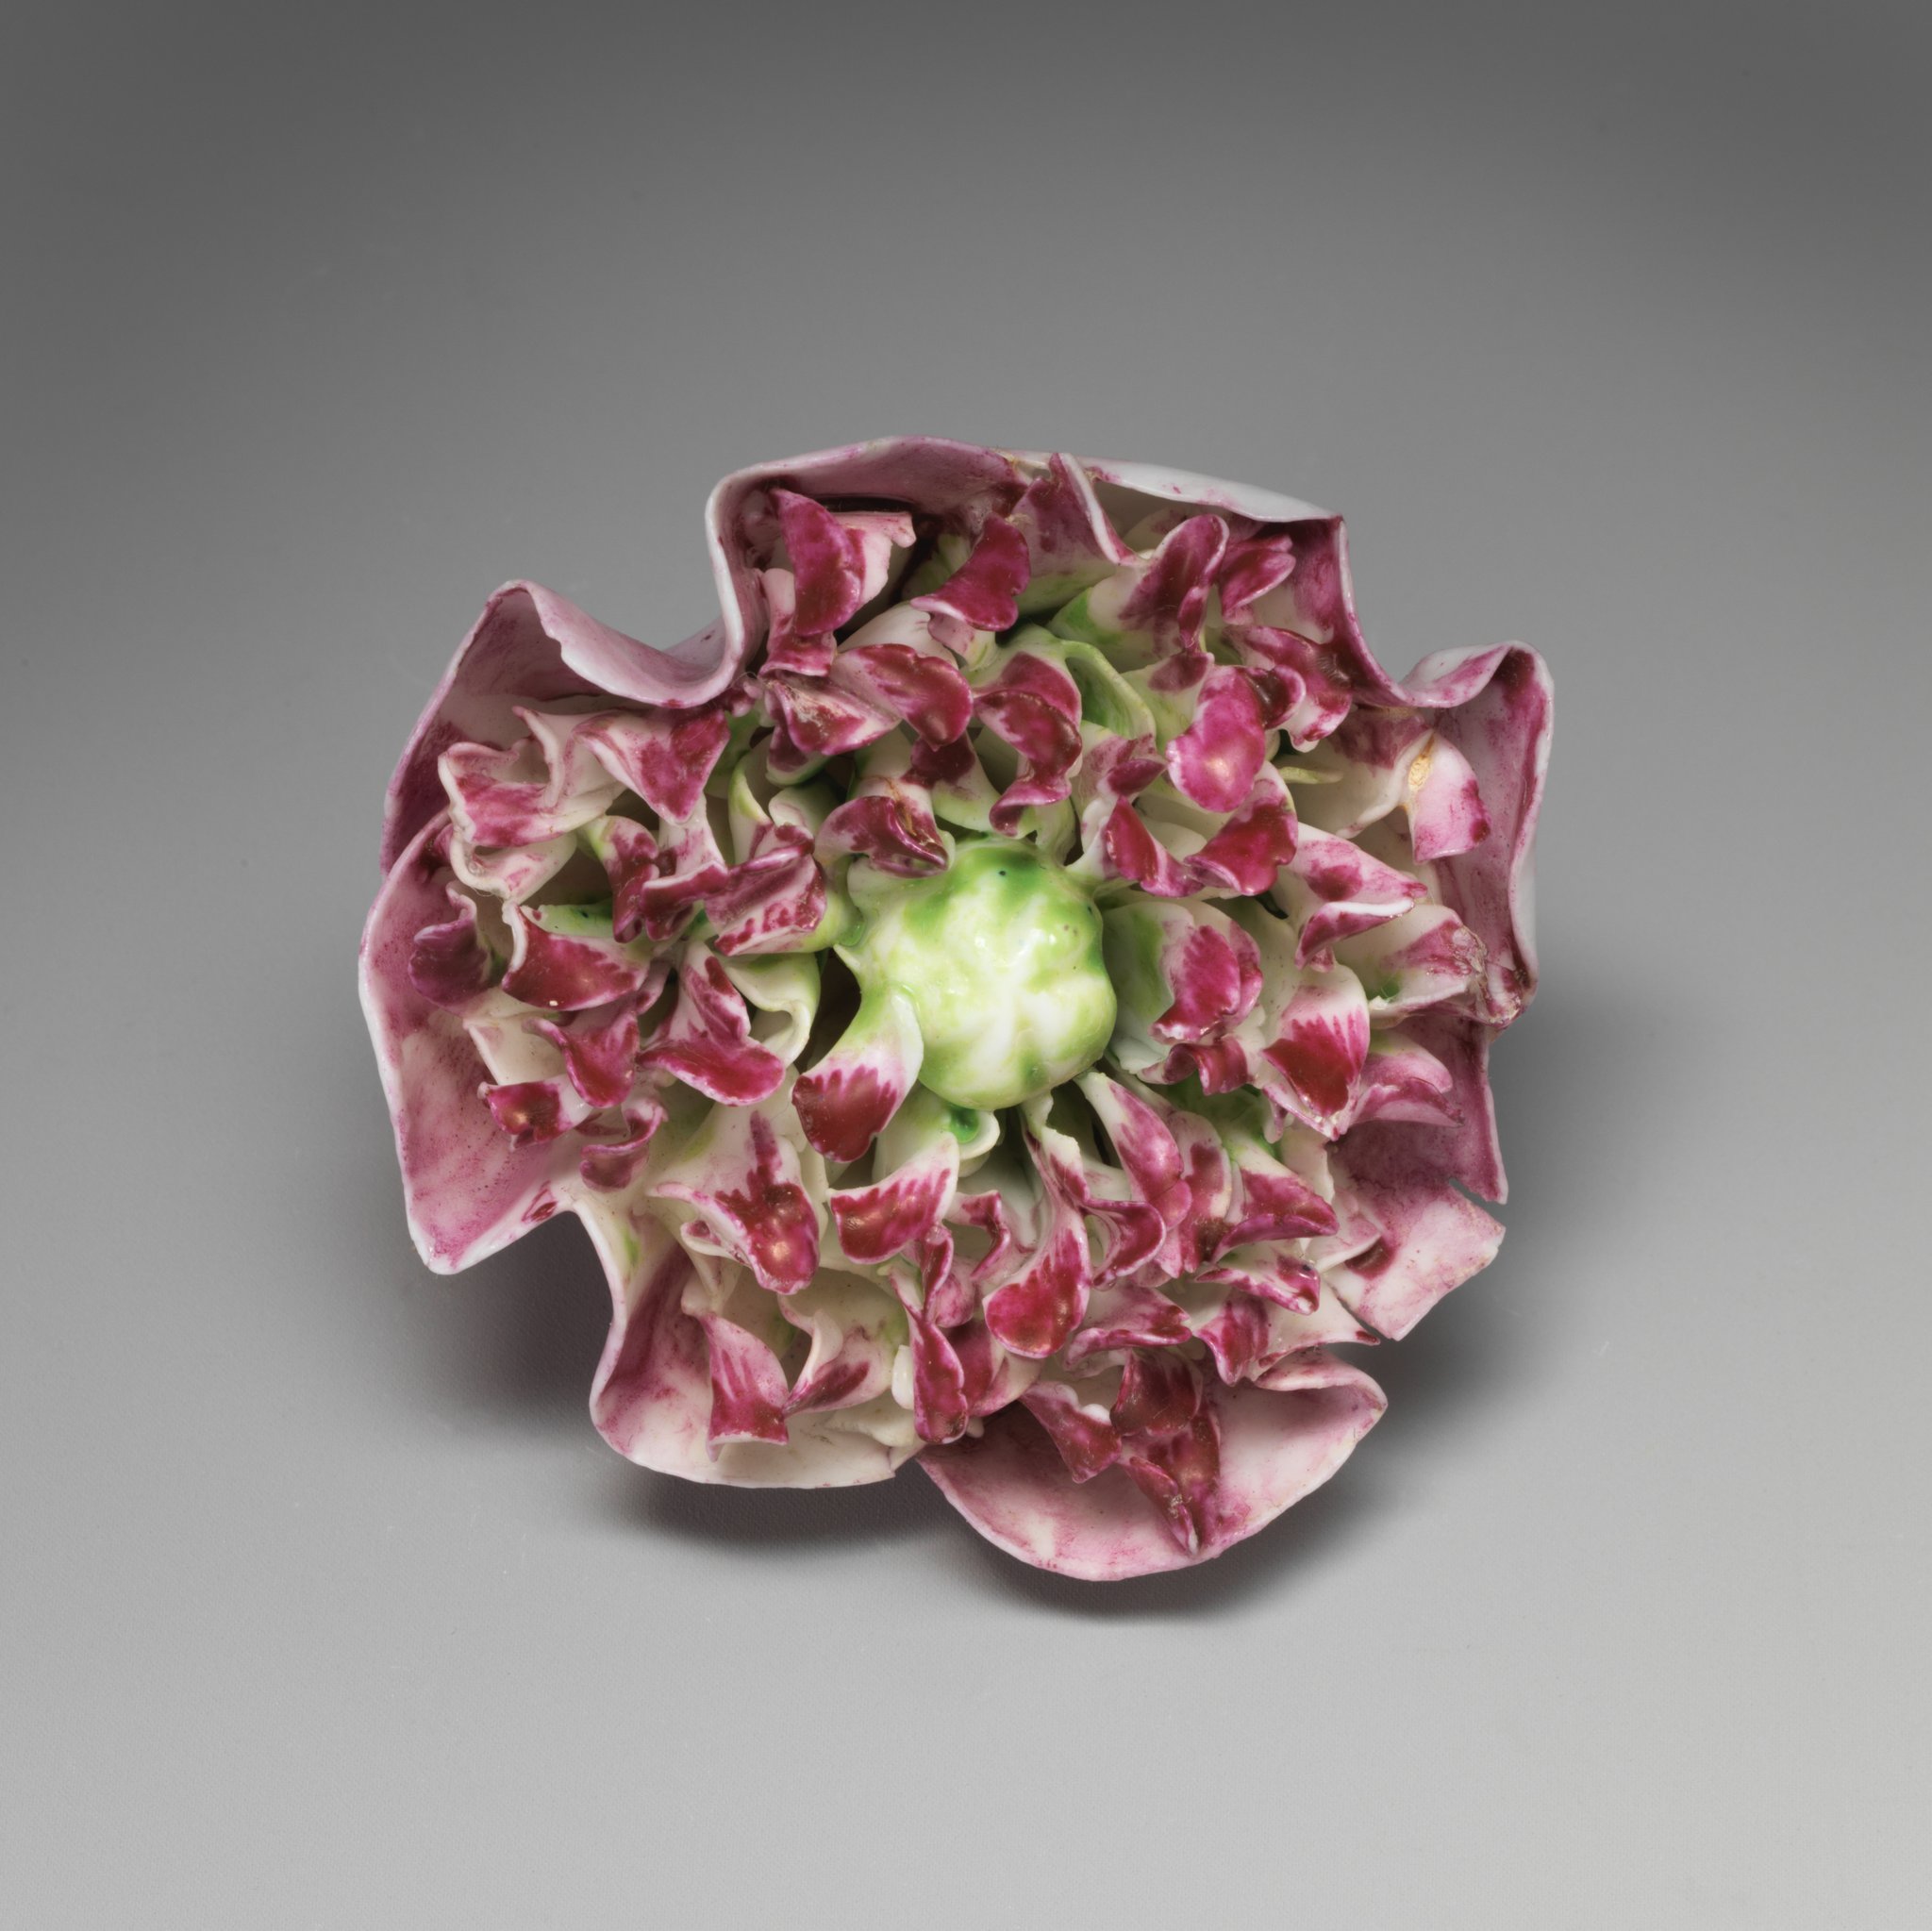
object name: porcelain flower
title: Porcelain flower (one of a set of nine)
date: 1734-1766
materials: soft paste porcelain